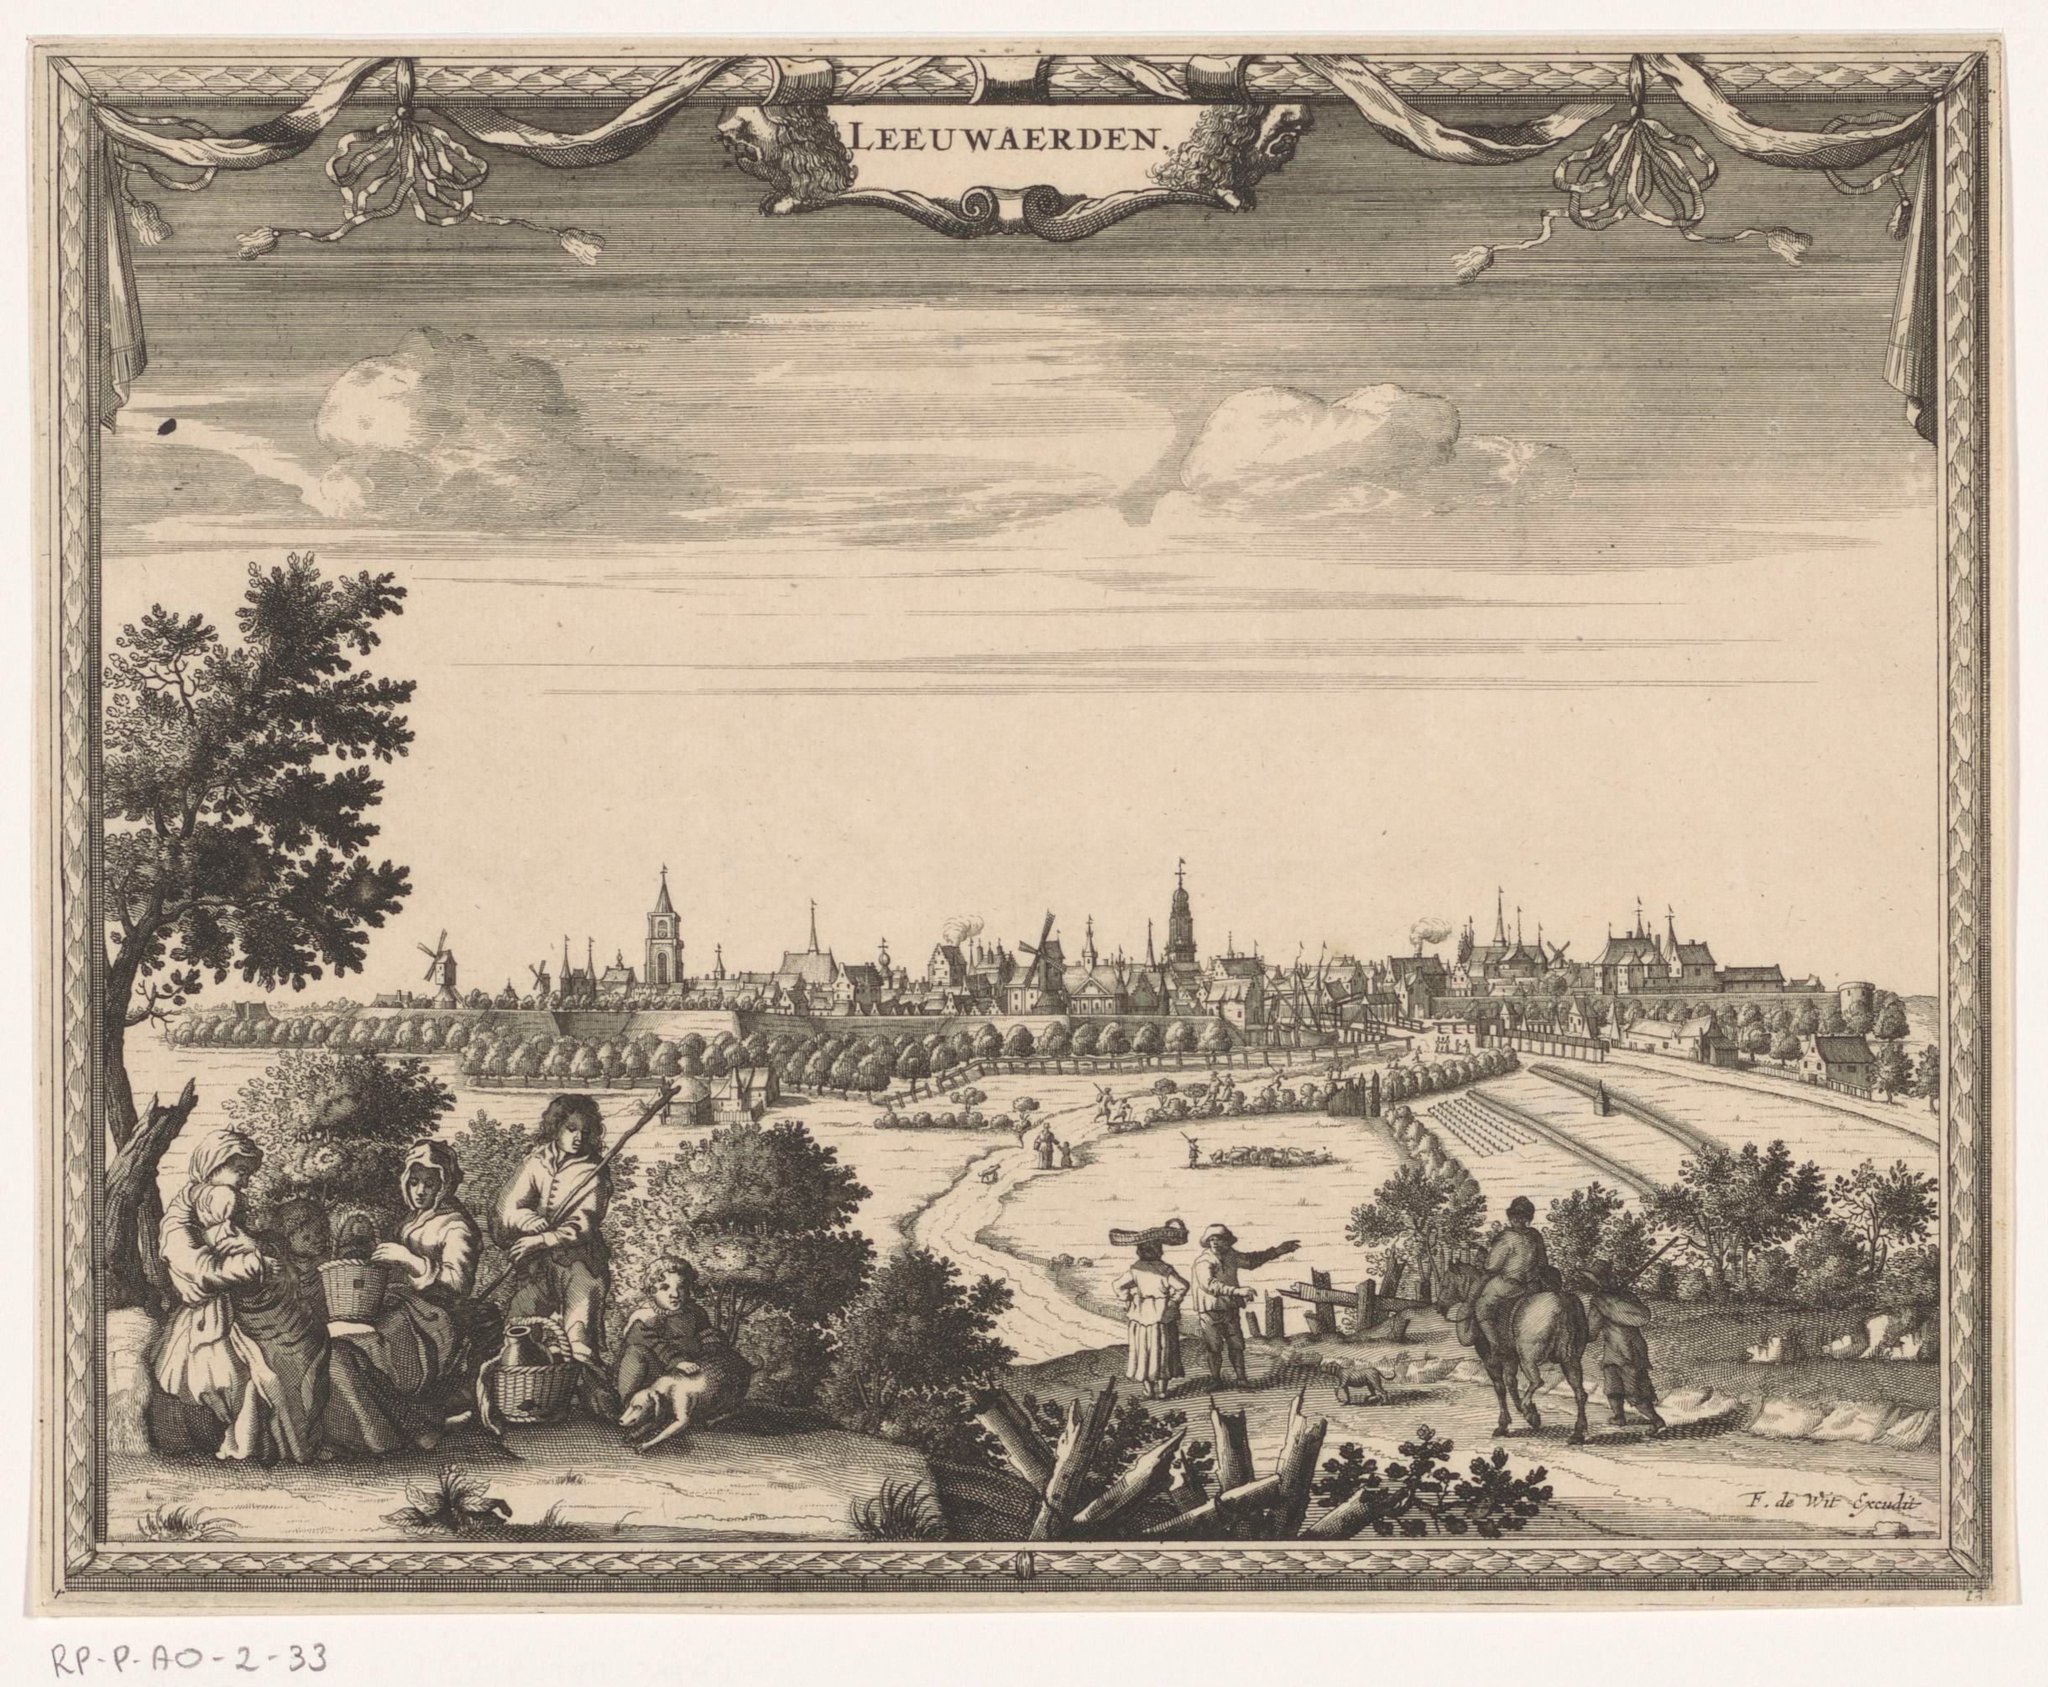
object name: print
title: Gezicht op Leeuwarden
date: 1648-1706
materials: paper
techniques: engraving, etching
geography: amsterdam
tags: city-view in general; 'veduta'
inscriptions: collector's mark: Lugt 195, collector's mark: Lugt 2228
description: Gezicht op Leeuwarden, met op de voorgrond enkele figuren.